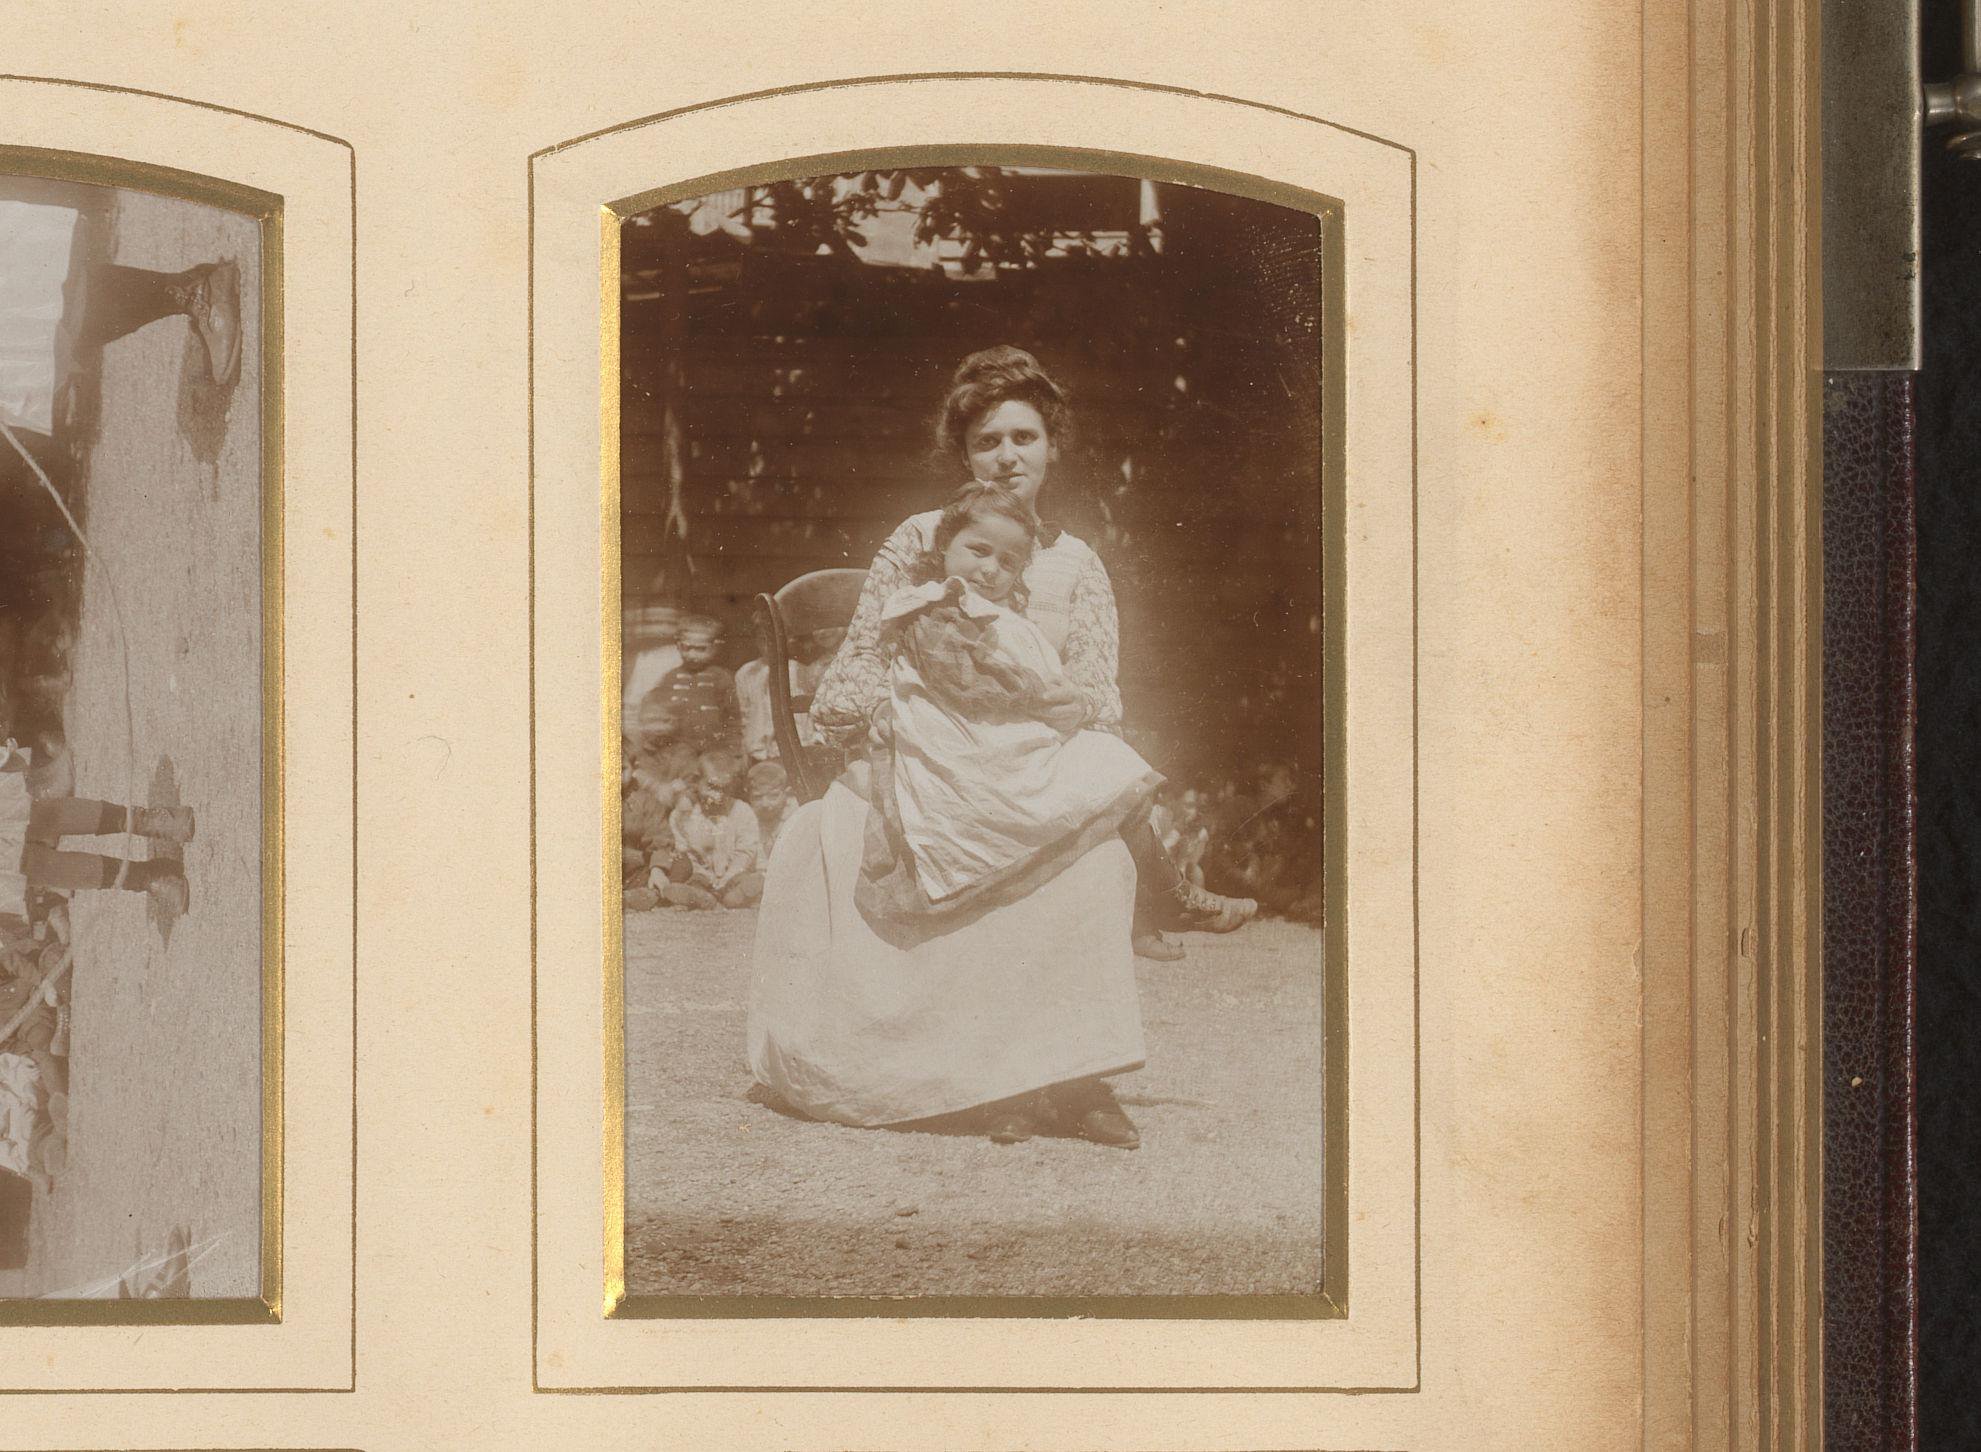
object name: photograph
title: Portret van een jonge vrouw met een meisje op schoot, zittend op een stoel in een tuin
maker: Anonymous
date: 1900-1910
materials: photographic support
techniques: collodion silver print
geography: netherlands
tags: garden, historical persons, toddler (female)